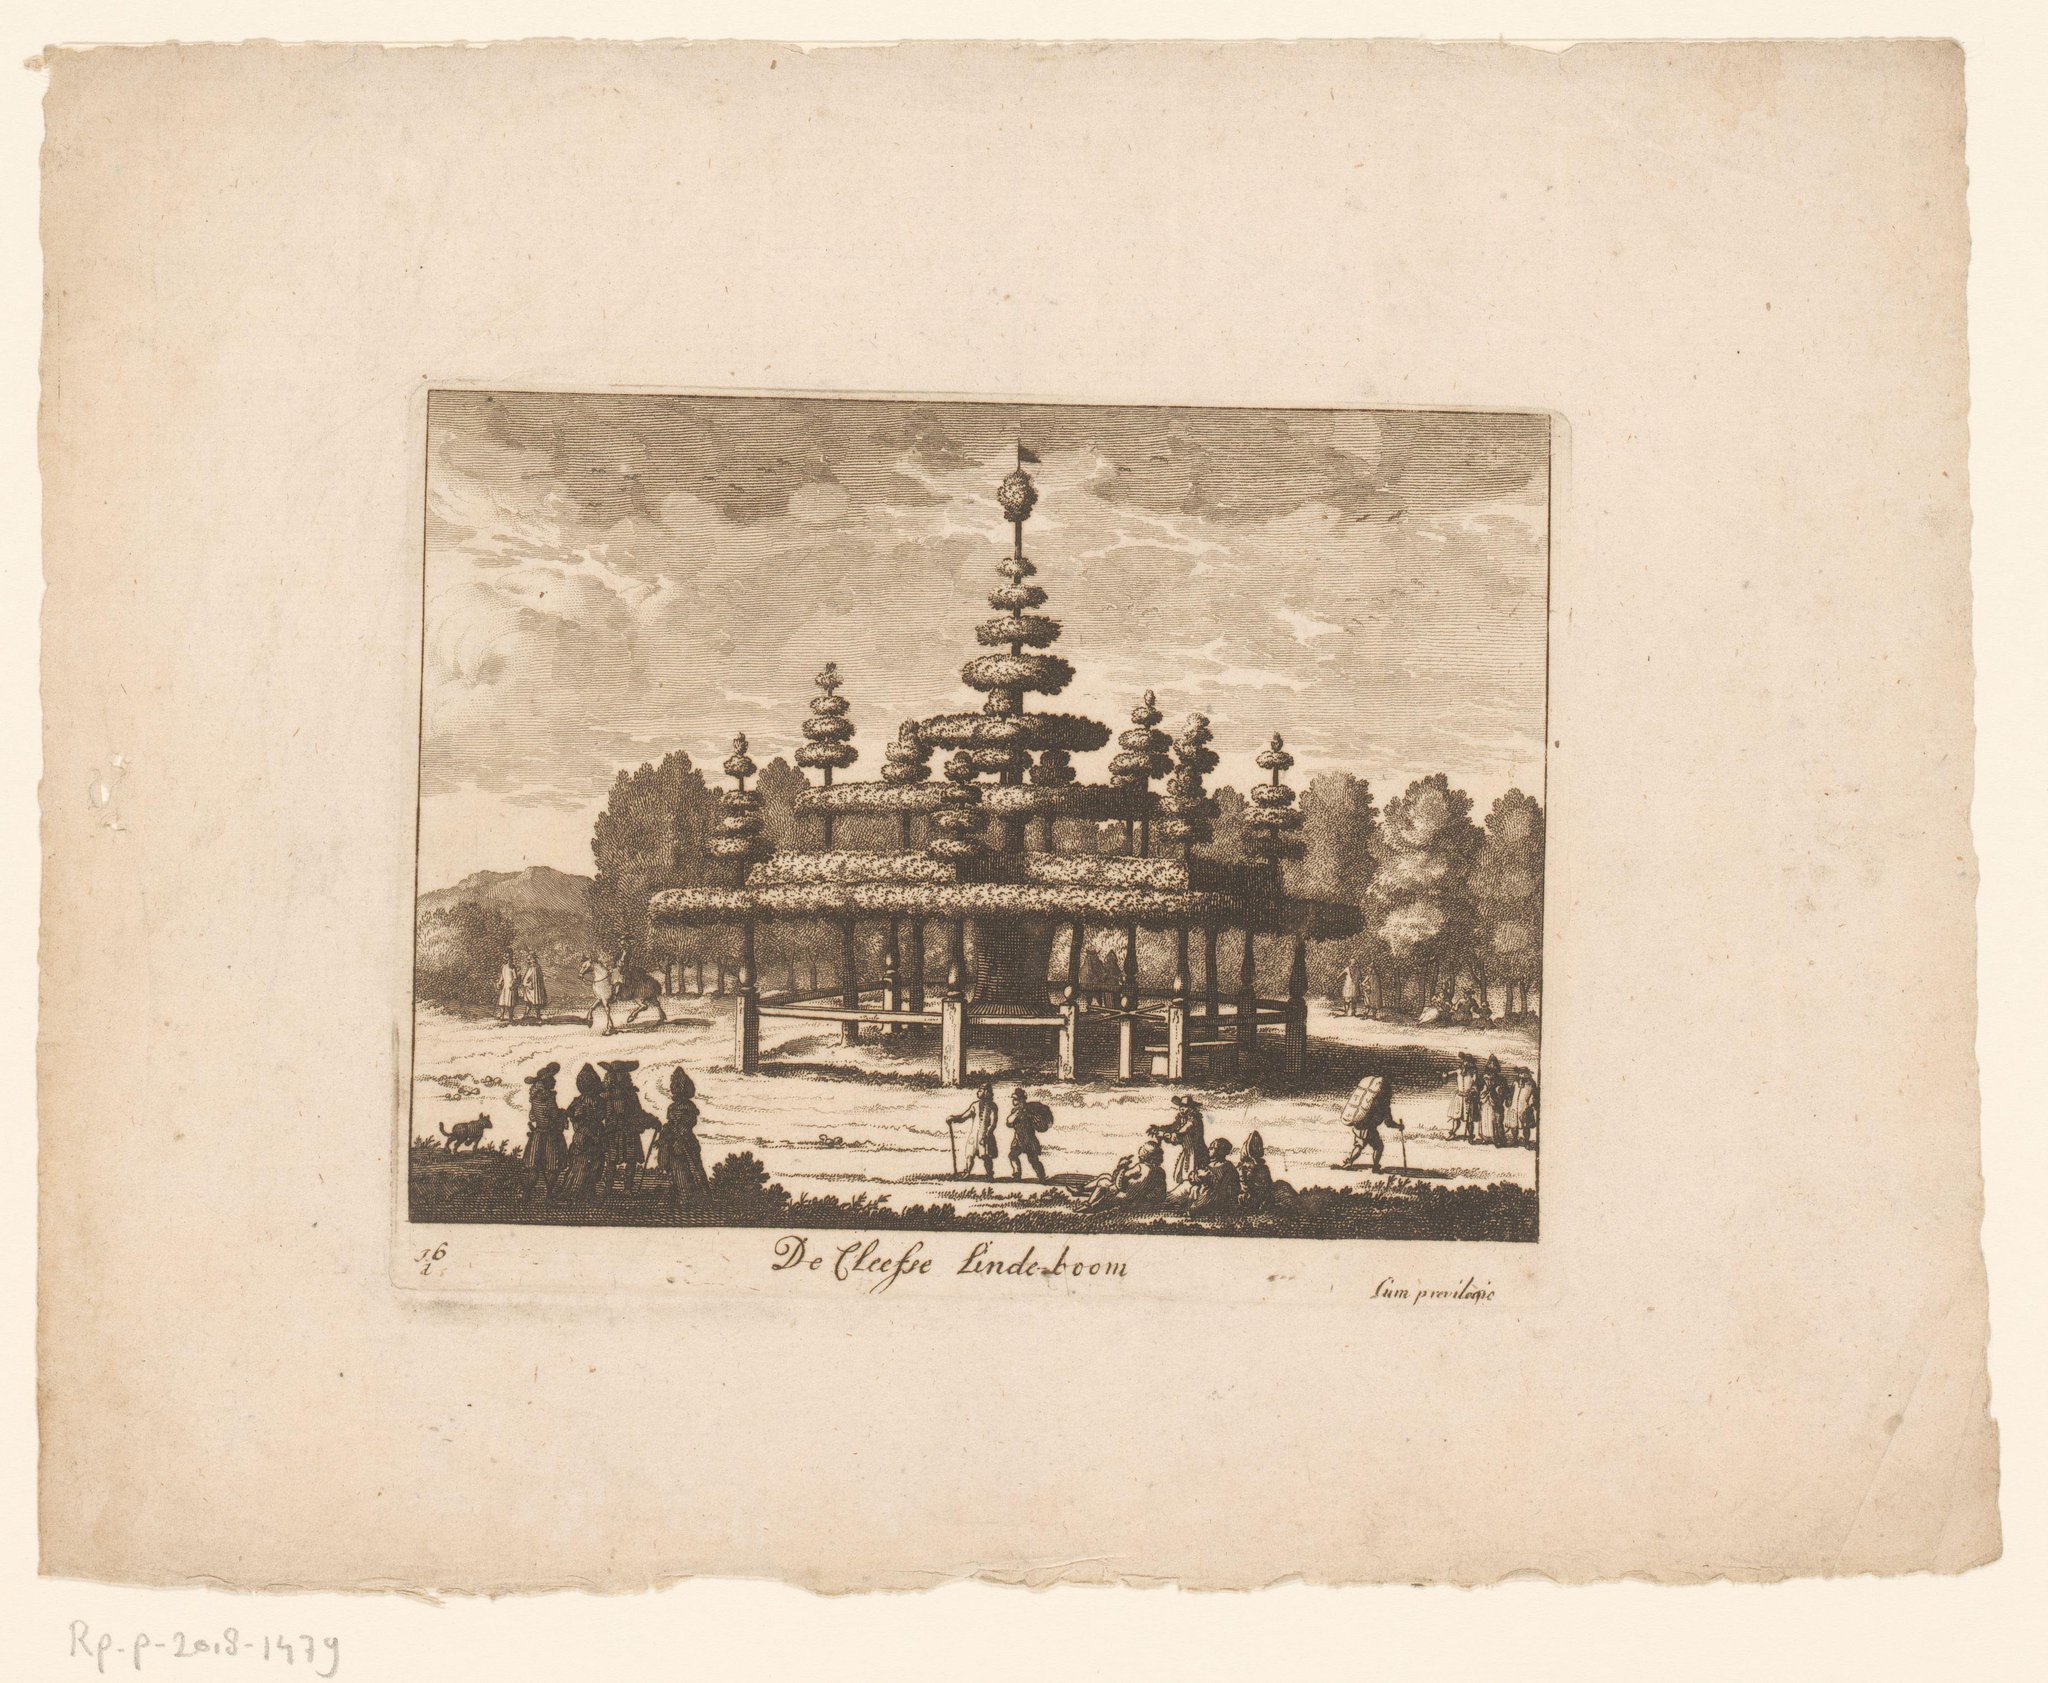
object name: print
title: De Cleefse lindeboom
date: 1695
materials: paper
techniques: etching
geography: amsterdam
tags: trees: linden, fabulous trees, cleves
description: Prent ook gebruikt in: Veues et perspectives de la ville de Cleves, et de sa cour. Amsterdam: Gerard Valck, 1695.